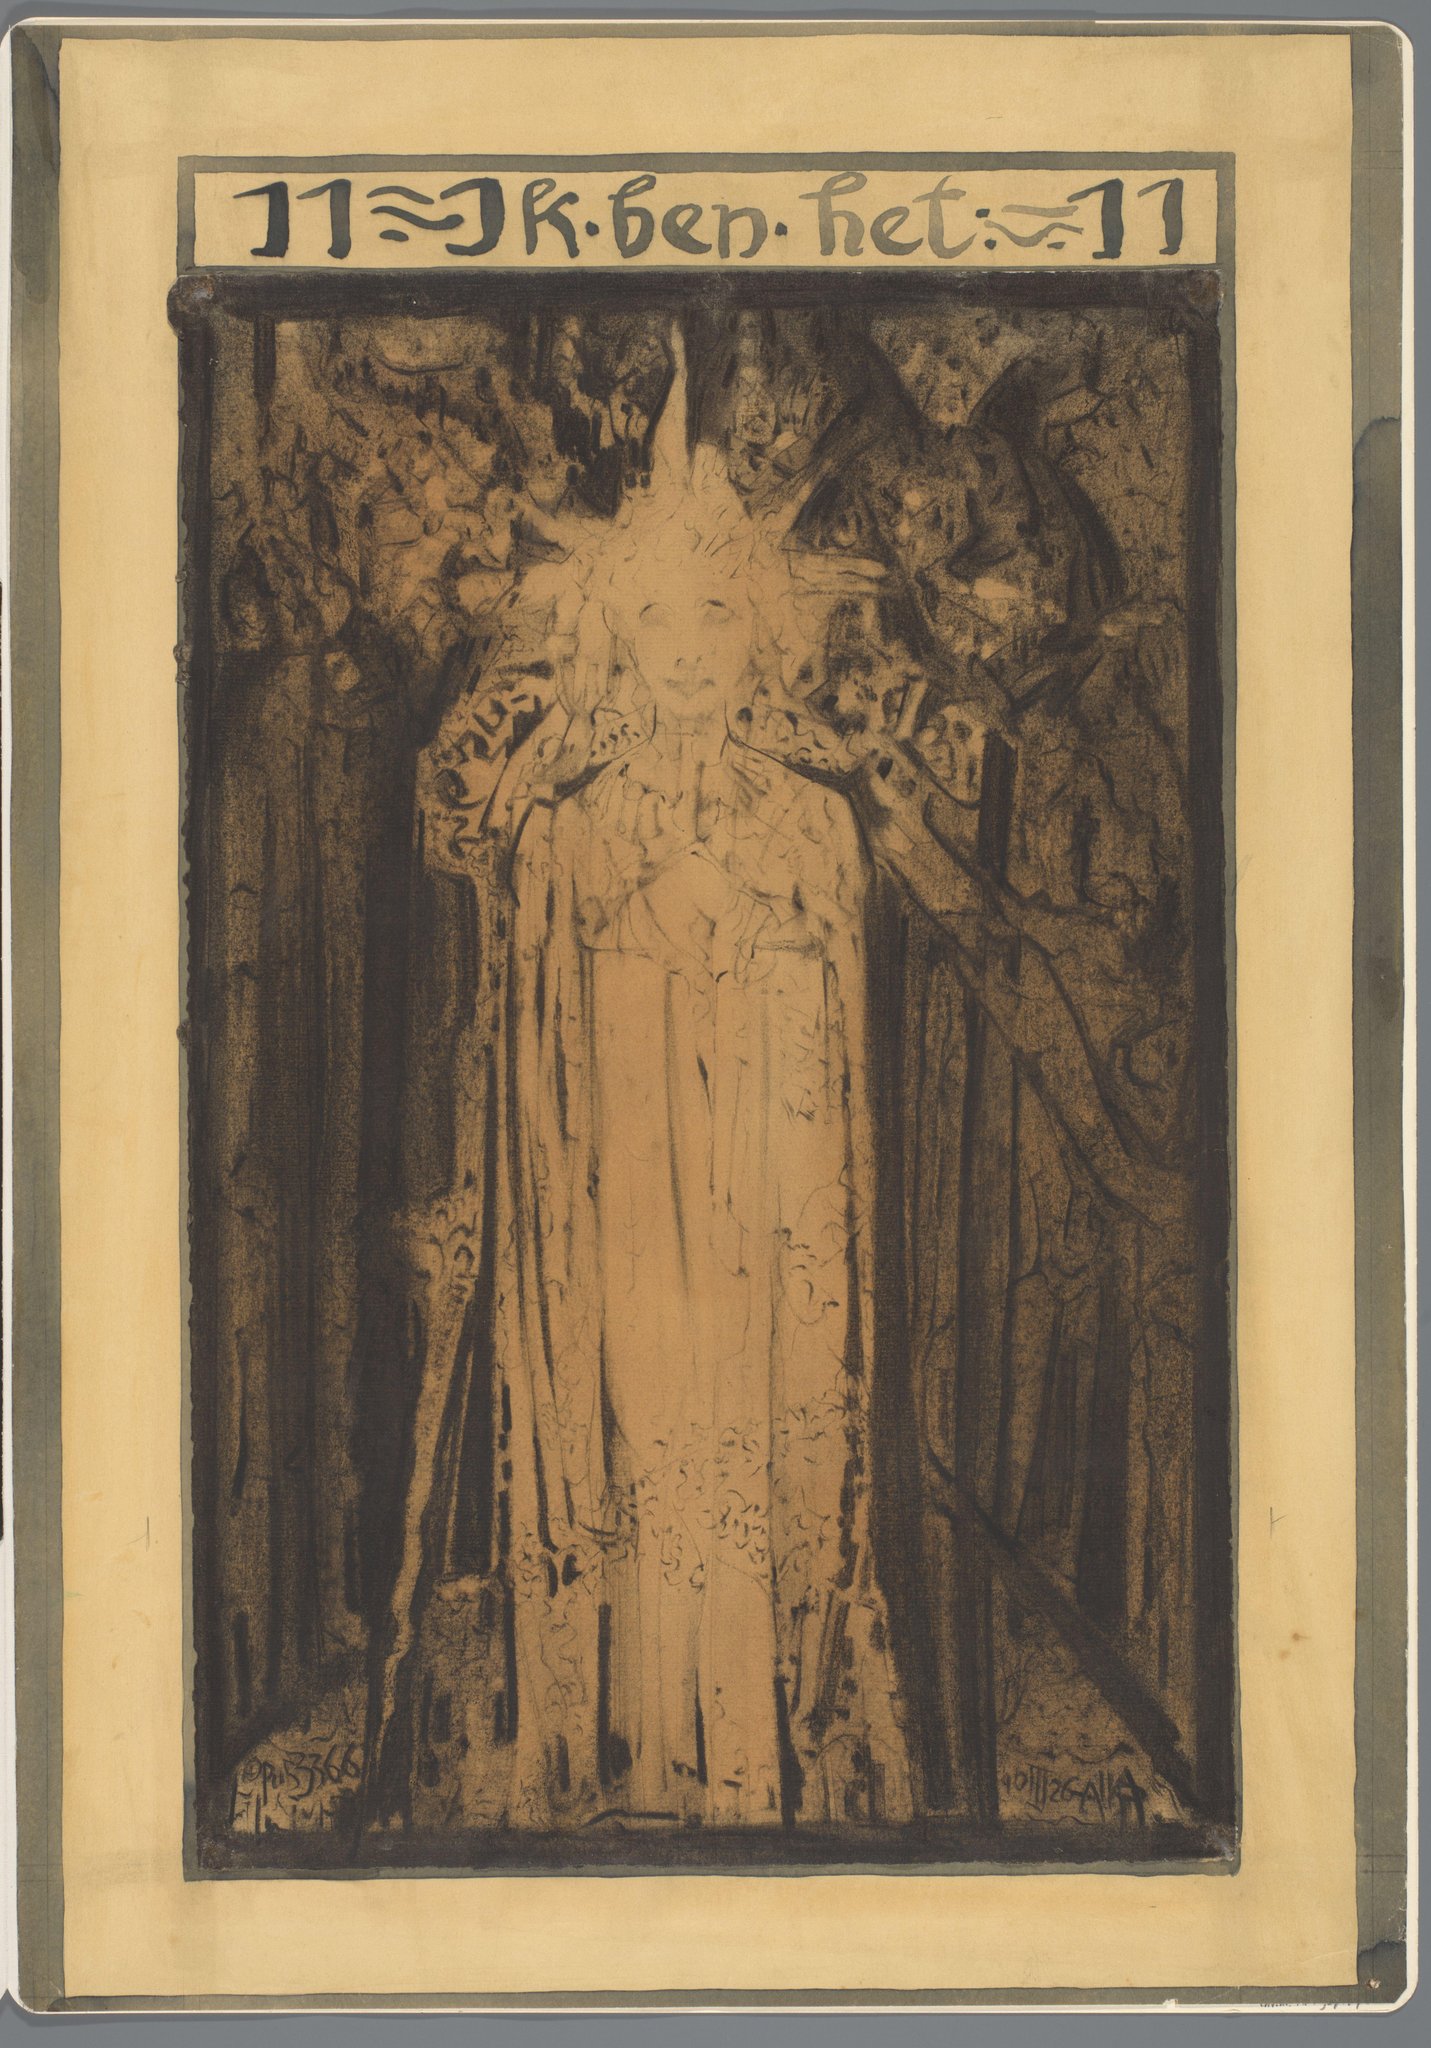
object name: drawing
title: Staande allegorische vrouwenfiguur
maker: albert plasschaert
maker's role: draughtsman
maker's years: 1866-1941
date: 1926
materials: charcoal, paper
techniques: brush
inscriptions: date: ‘10 III 26’, inscription: ‘Ik ben het’